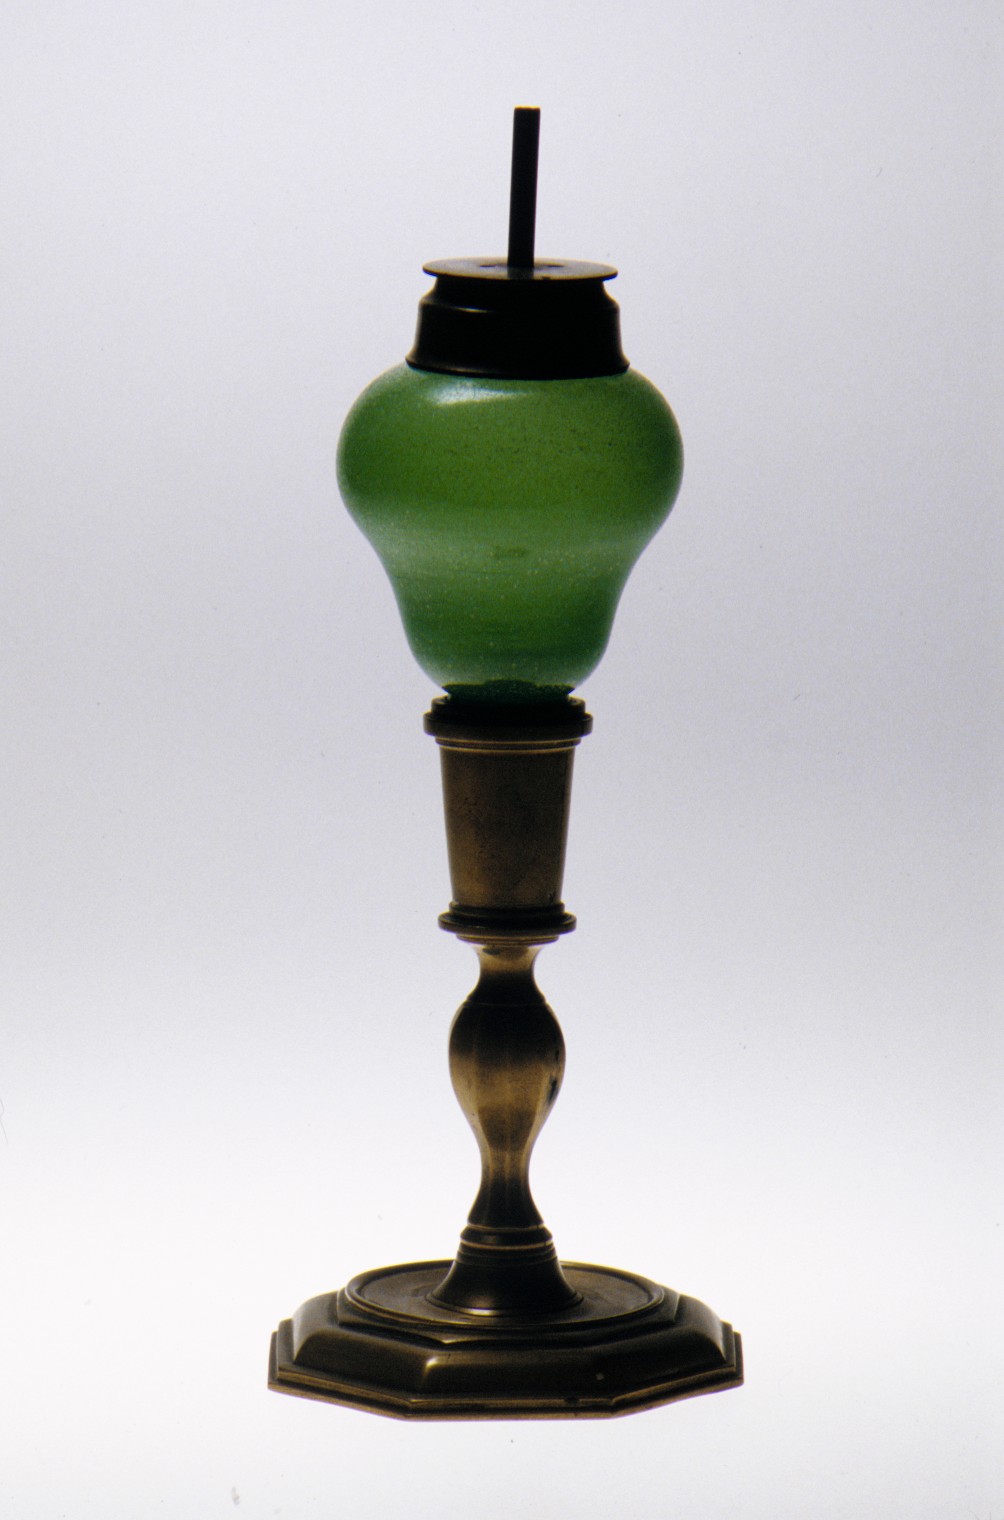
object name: peg lamp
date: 1850-1870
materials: brass, glass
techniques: pressed